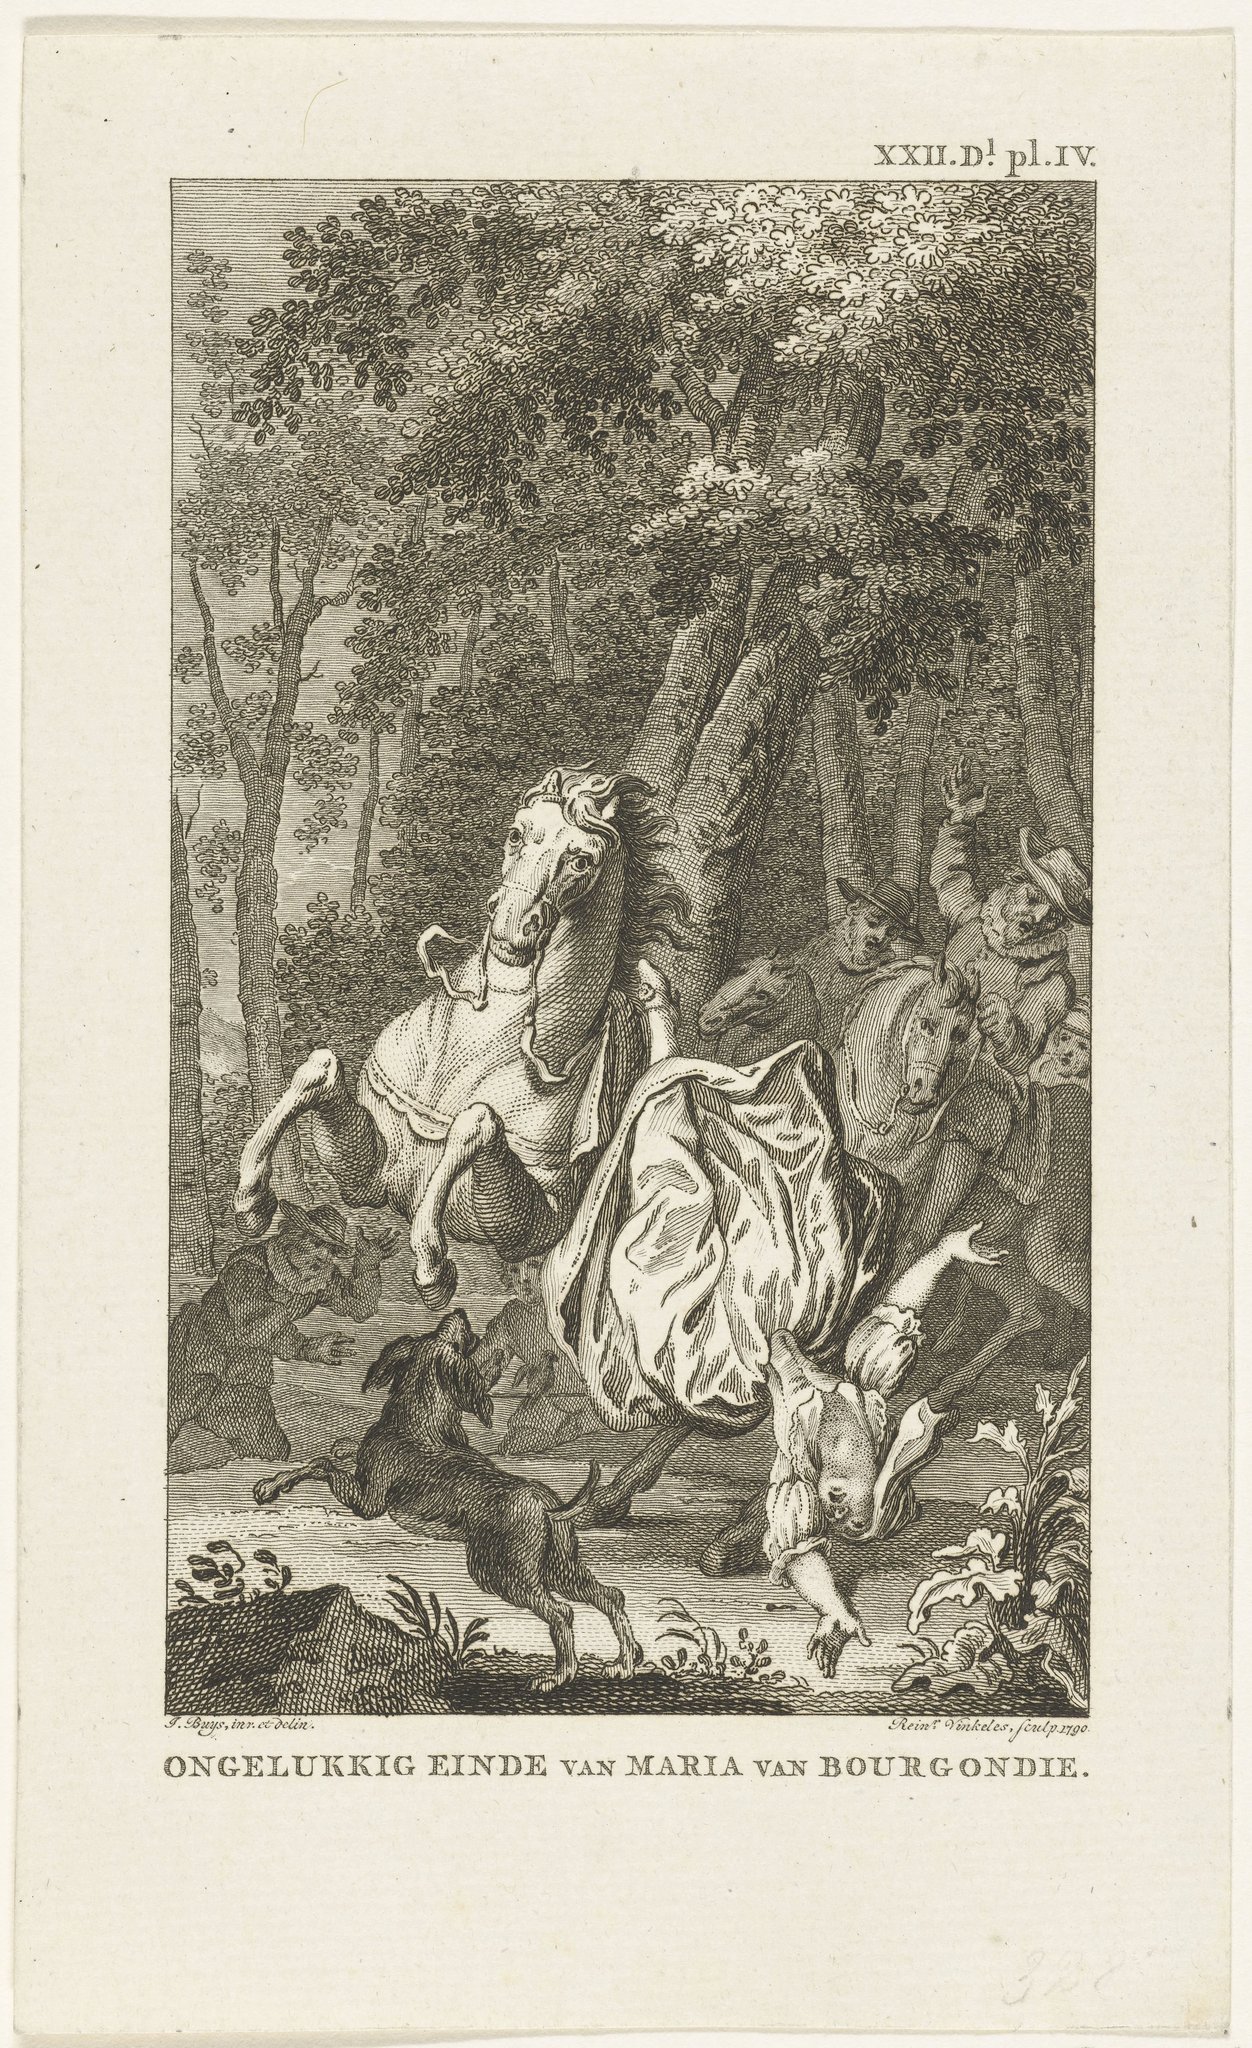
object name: print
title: Ongelukkig einde van Maria van Bourgondie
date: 1790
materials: paper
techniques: etching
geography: netherlands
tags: brussels, bruges, maria (hertogin van bourgondië), dying from the effects of a fall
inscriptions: date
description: Illustratie voor: Jacobus Kok, Vaderlandsch Woordenboek, Johannes Allart, Amsterdam 1785-1799, 35 delen, dl. XXII, pl. IV. Staat met de letter.